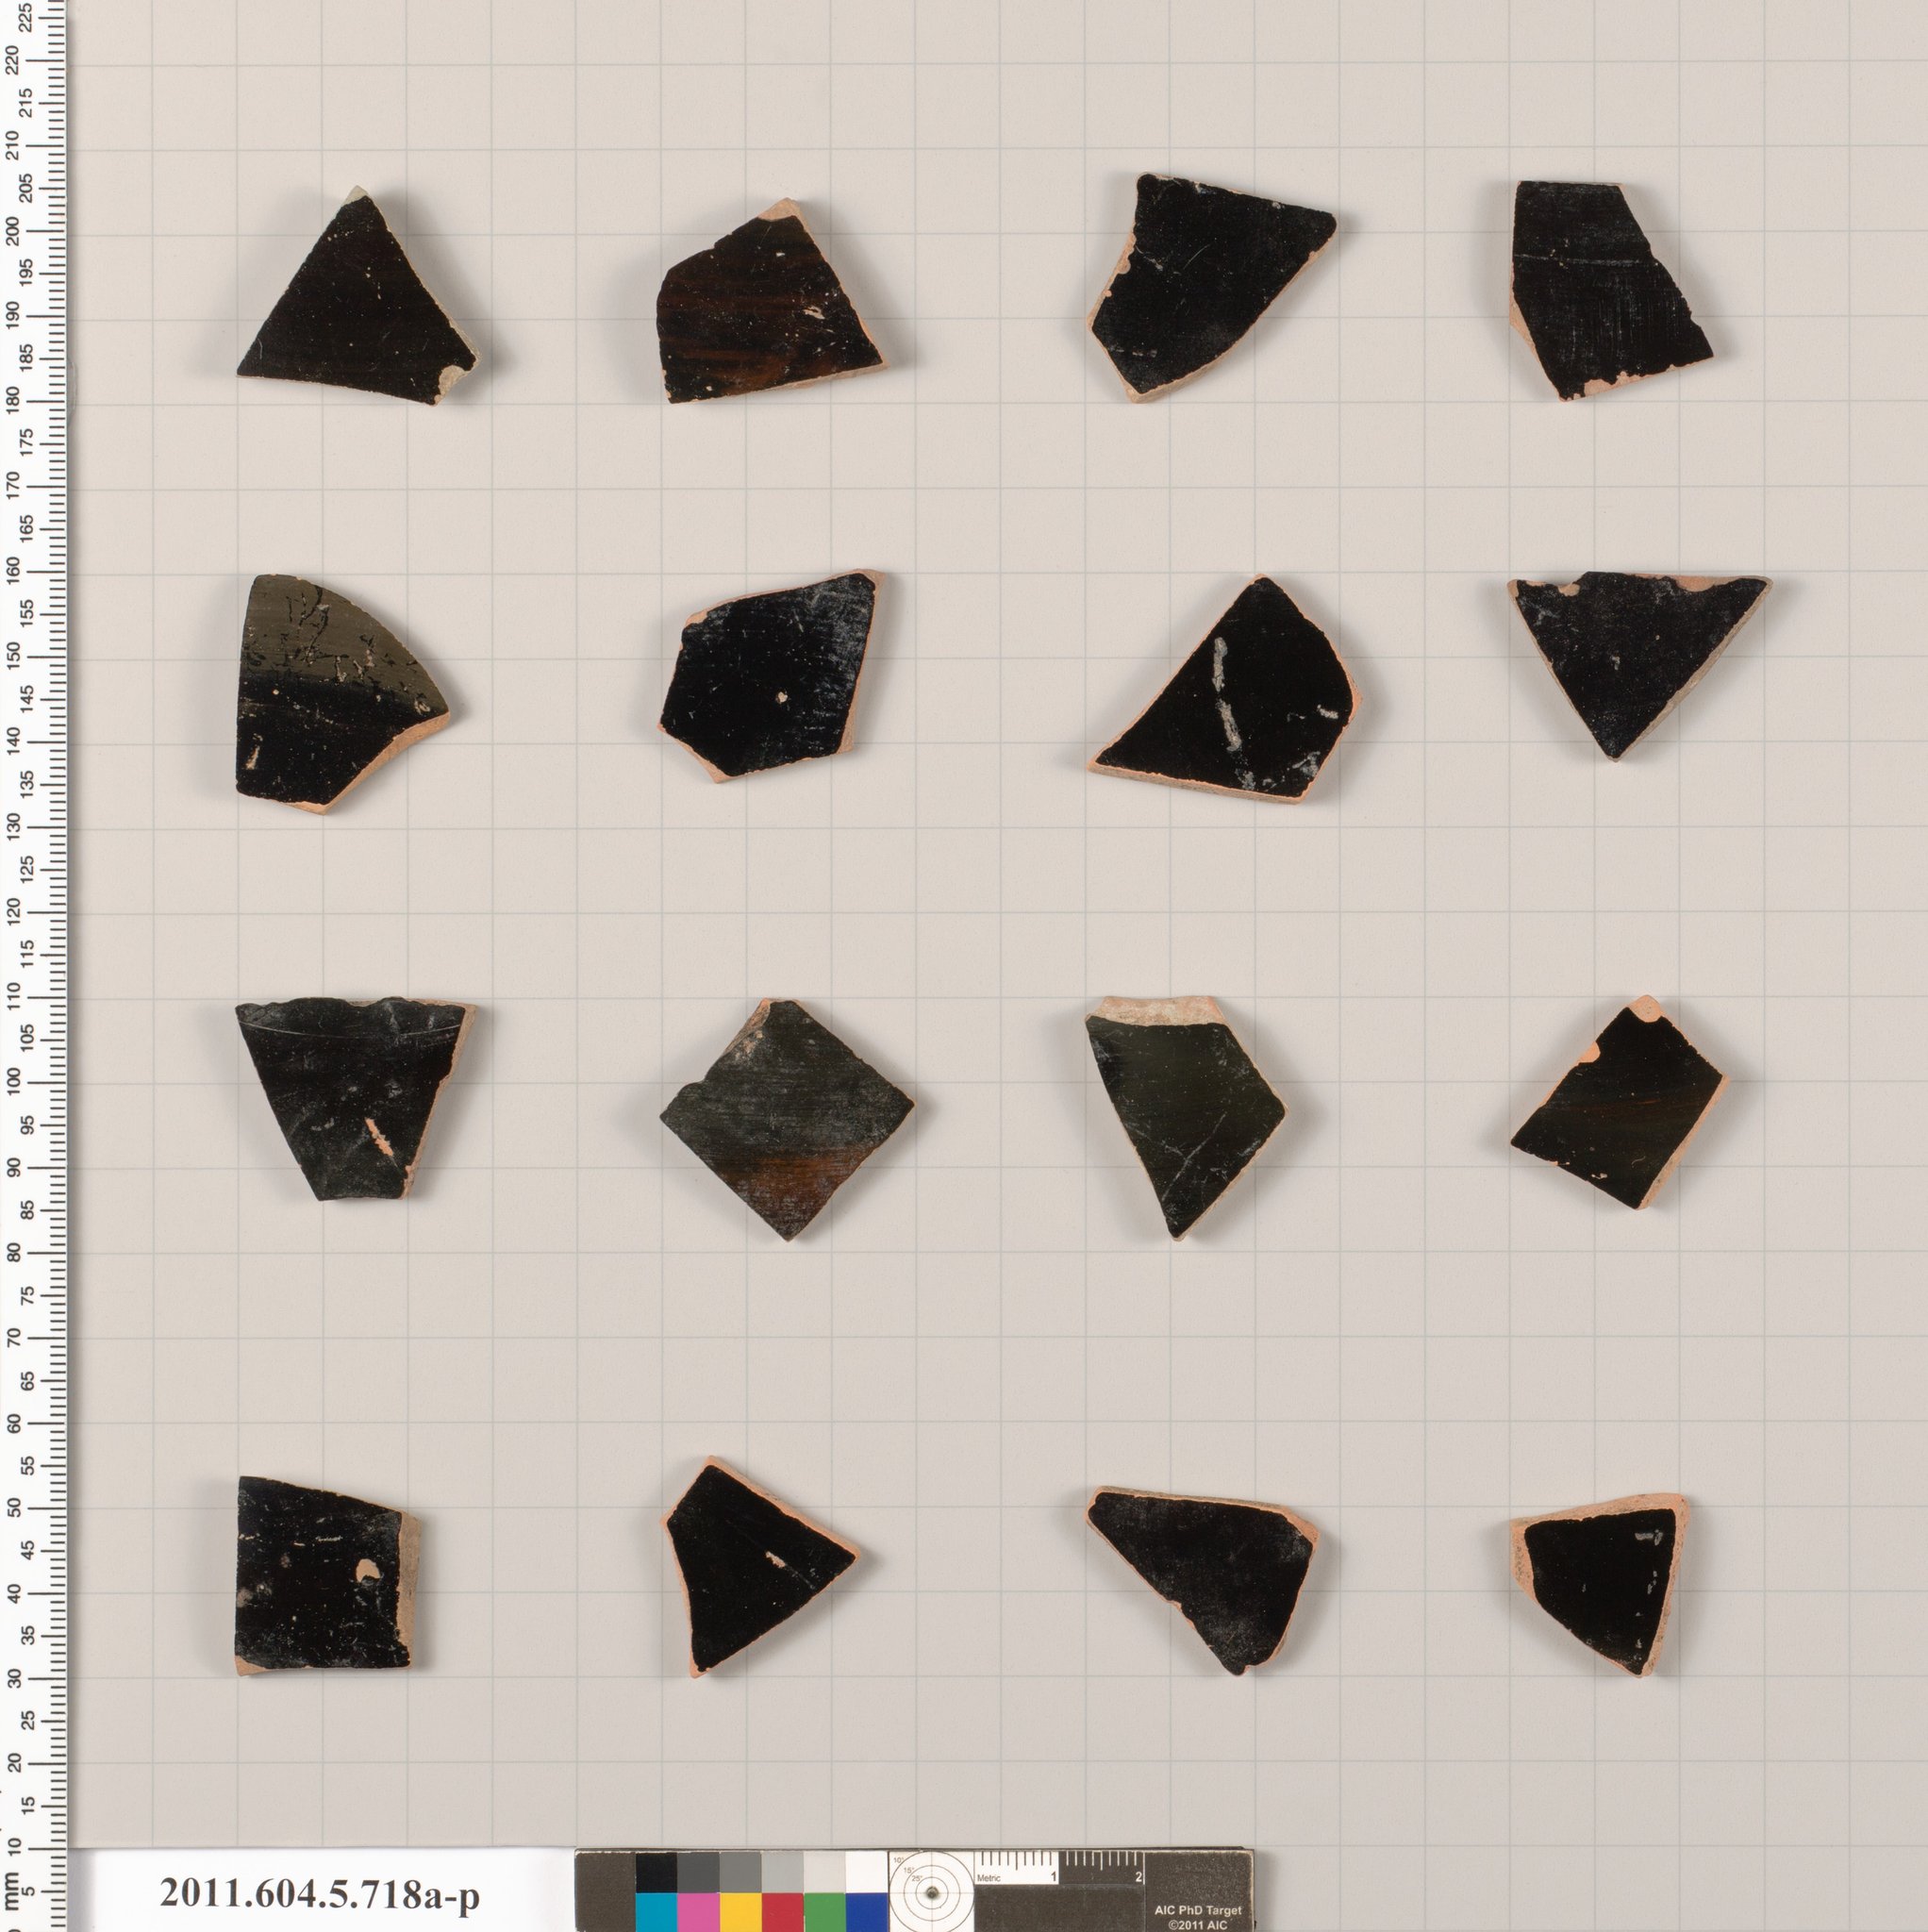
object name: kylix fragment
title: Terracotta fragments of kylikes (drinking cups)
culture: greek, attic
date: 600-401 BCE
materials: terracotta